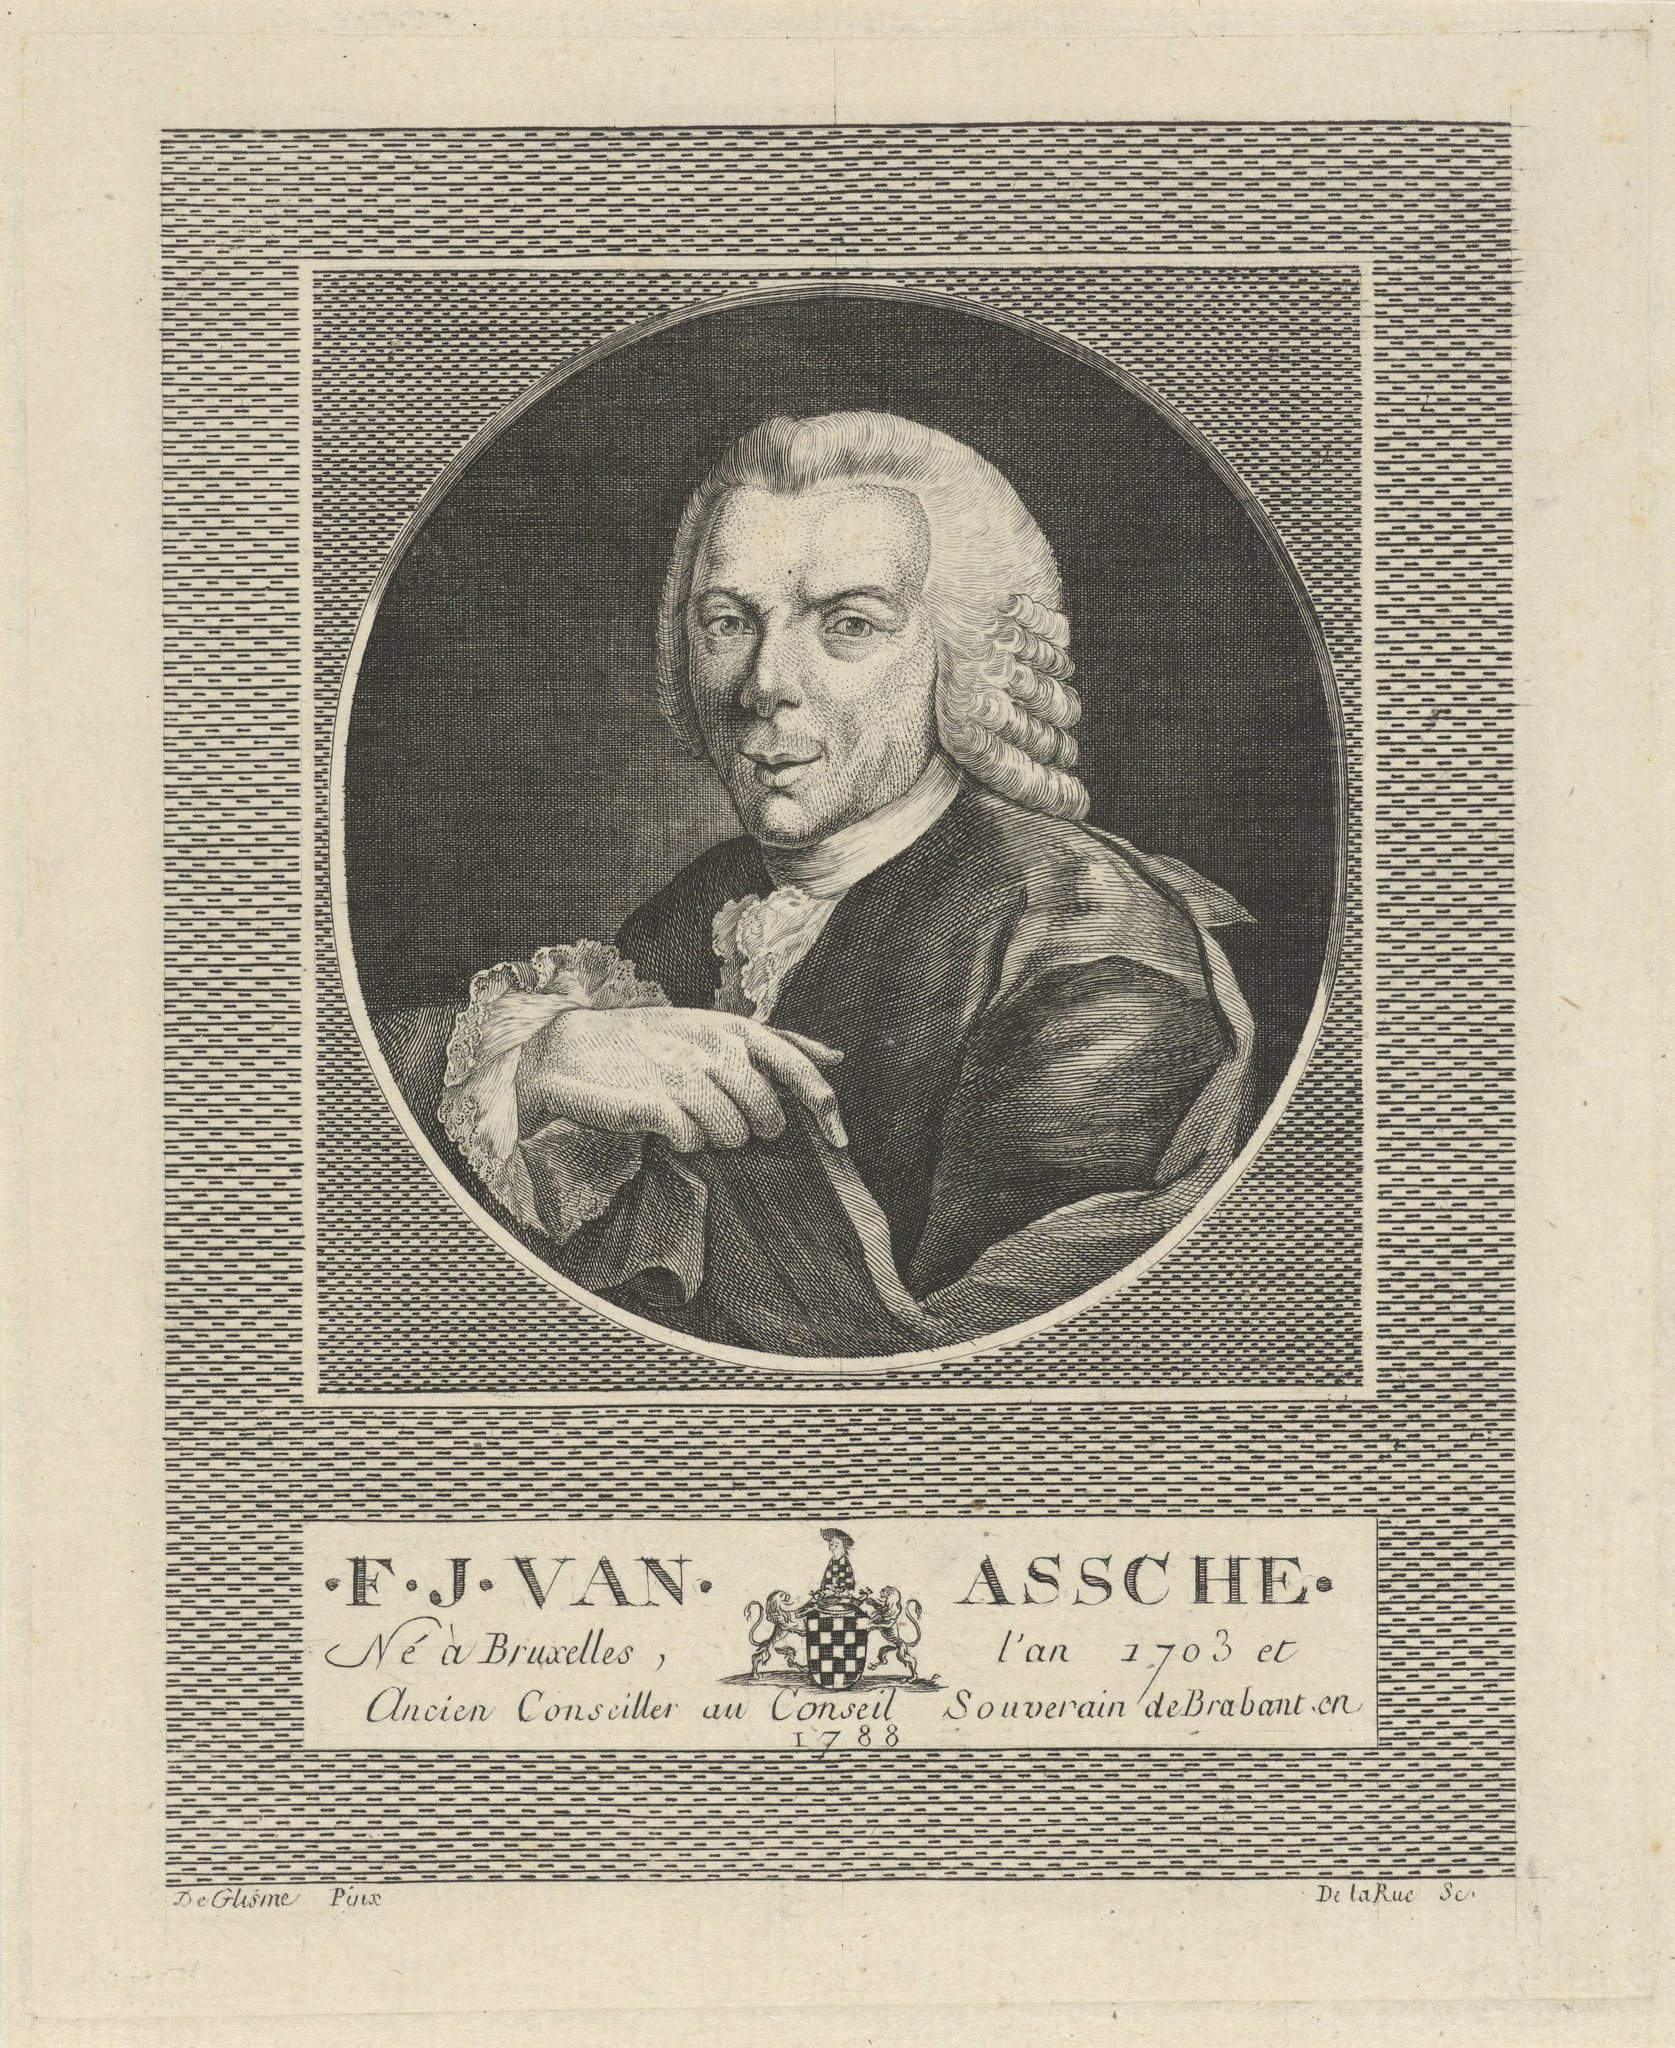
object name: print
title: Portret van F.J. van Assche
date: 1788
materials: paper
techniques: engraving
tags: brussels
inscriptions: collector's mark: Lugt 2228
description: Portretbuste naar links van F.J. van Assche, oud-raadsheer in de Hoge Raad van Brabant, blootshoofds. Het portret is gevat in een cirkelvormige omlijsting en onderaan voorzien van de naam, geboortegegevens, wapenschild en functie van de geportretteerde in het Frans.